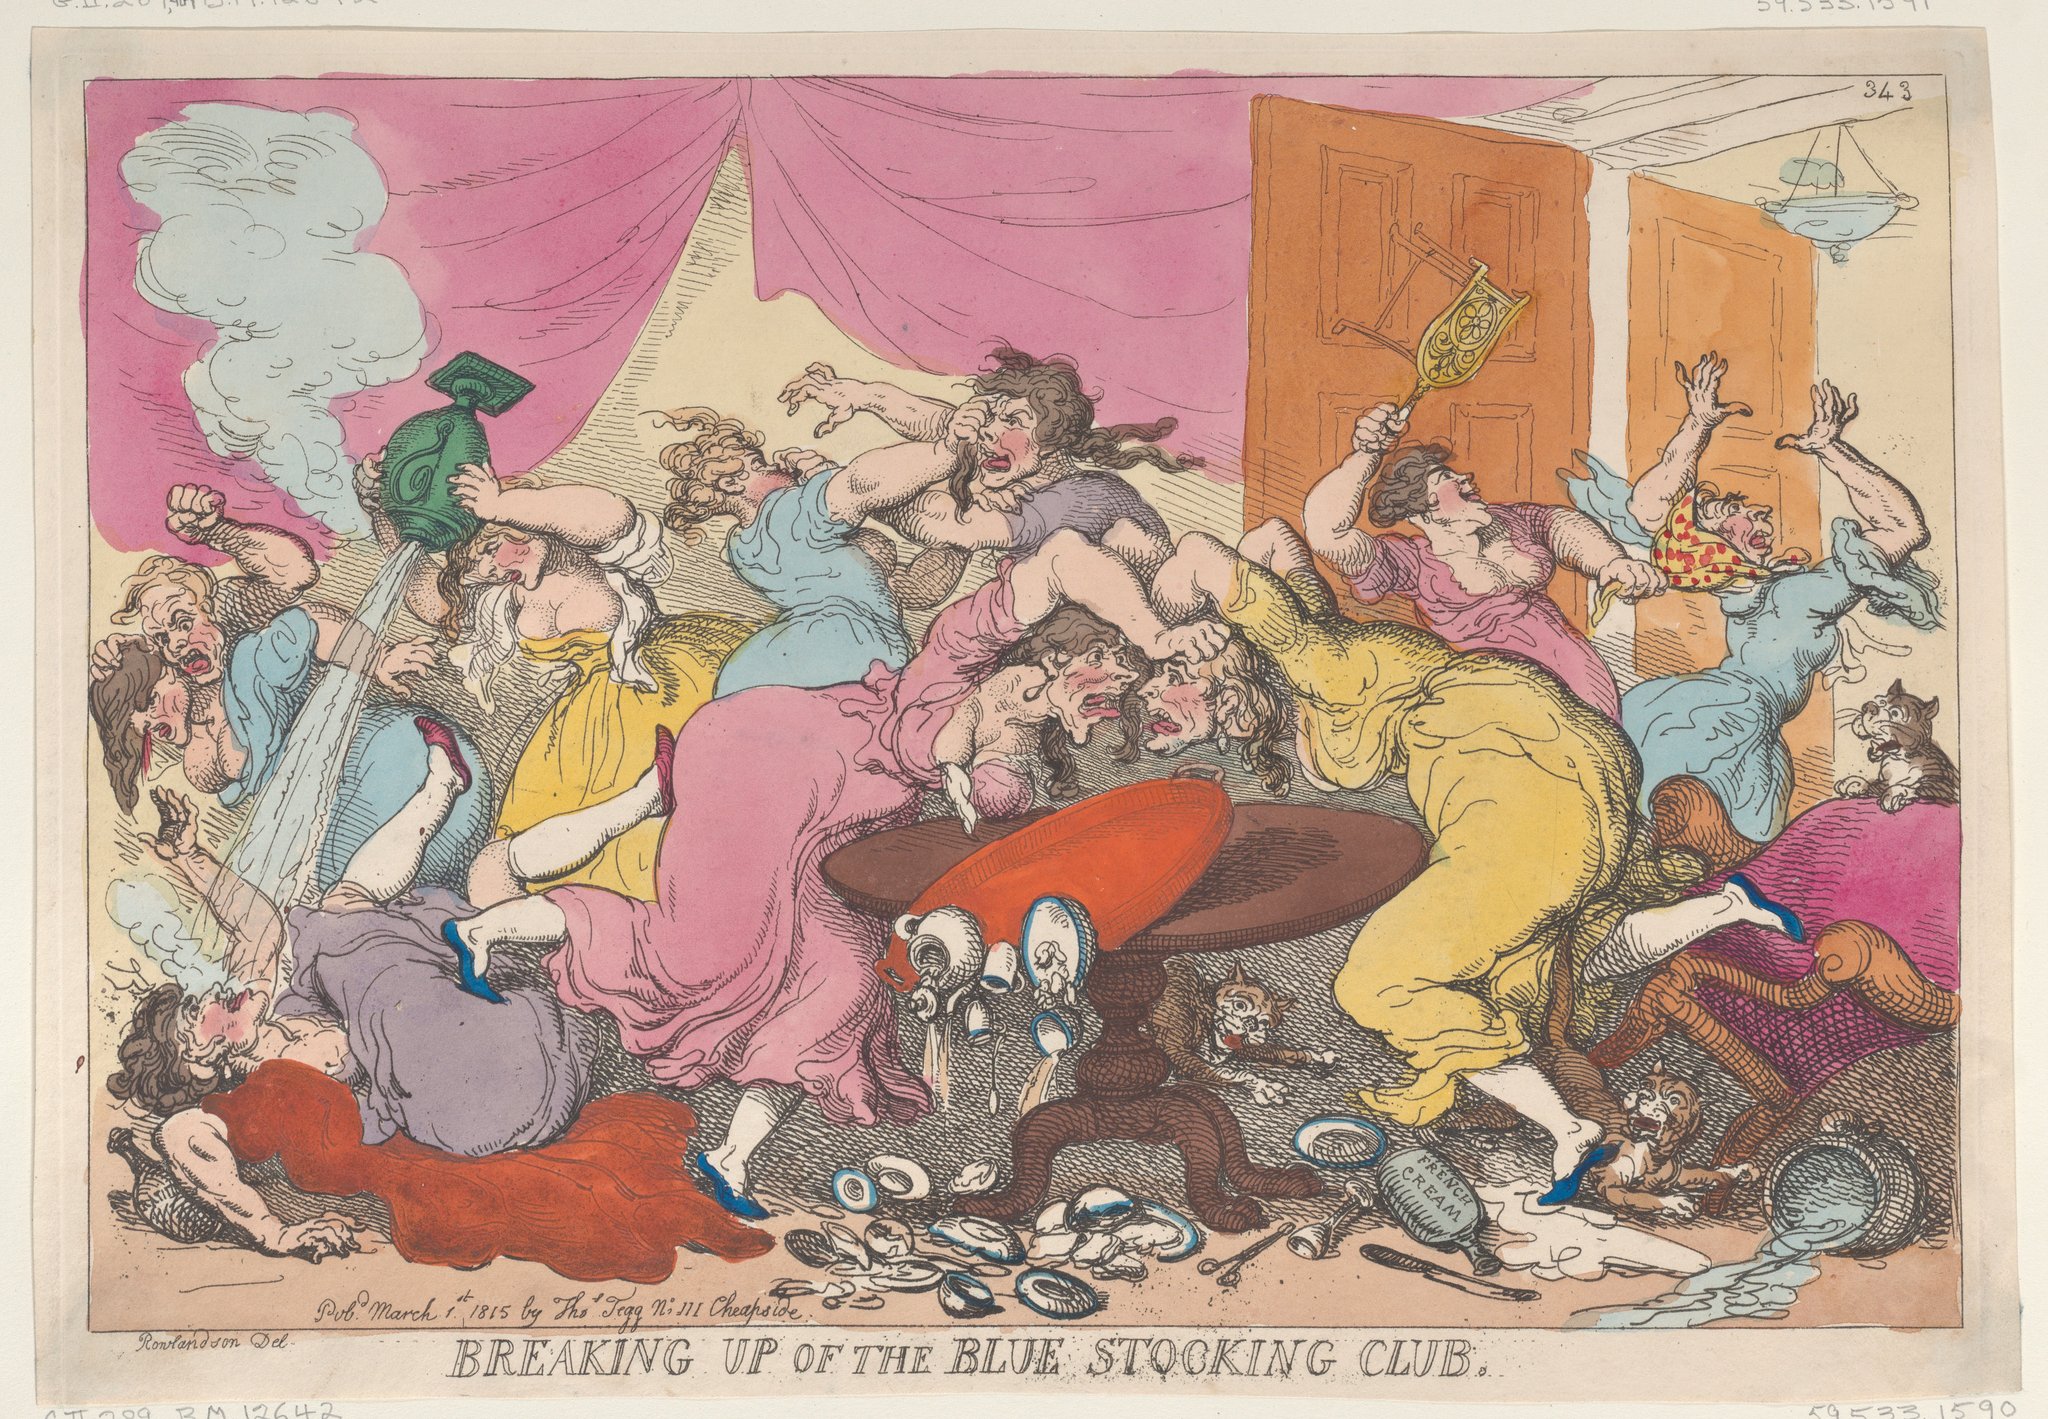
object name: print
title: Breaking Up of the Blue Stocking Club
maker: thomas rowlandson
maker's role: artist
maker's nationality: british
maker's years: 1757-1827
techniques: etching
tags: satire,women,cats